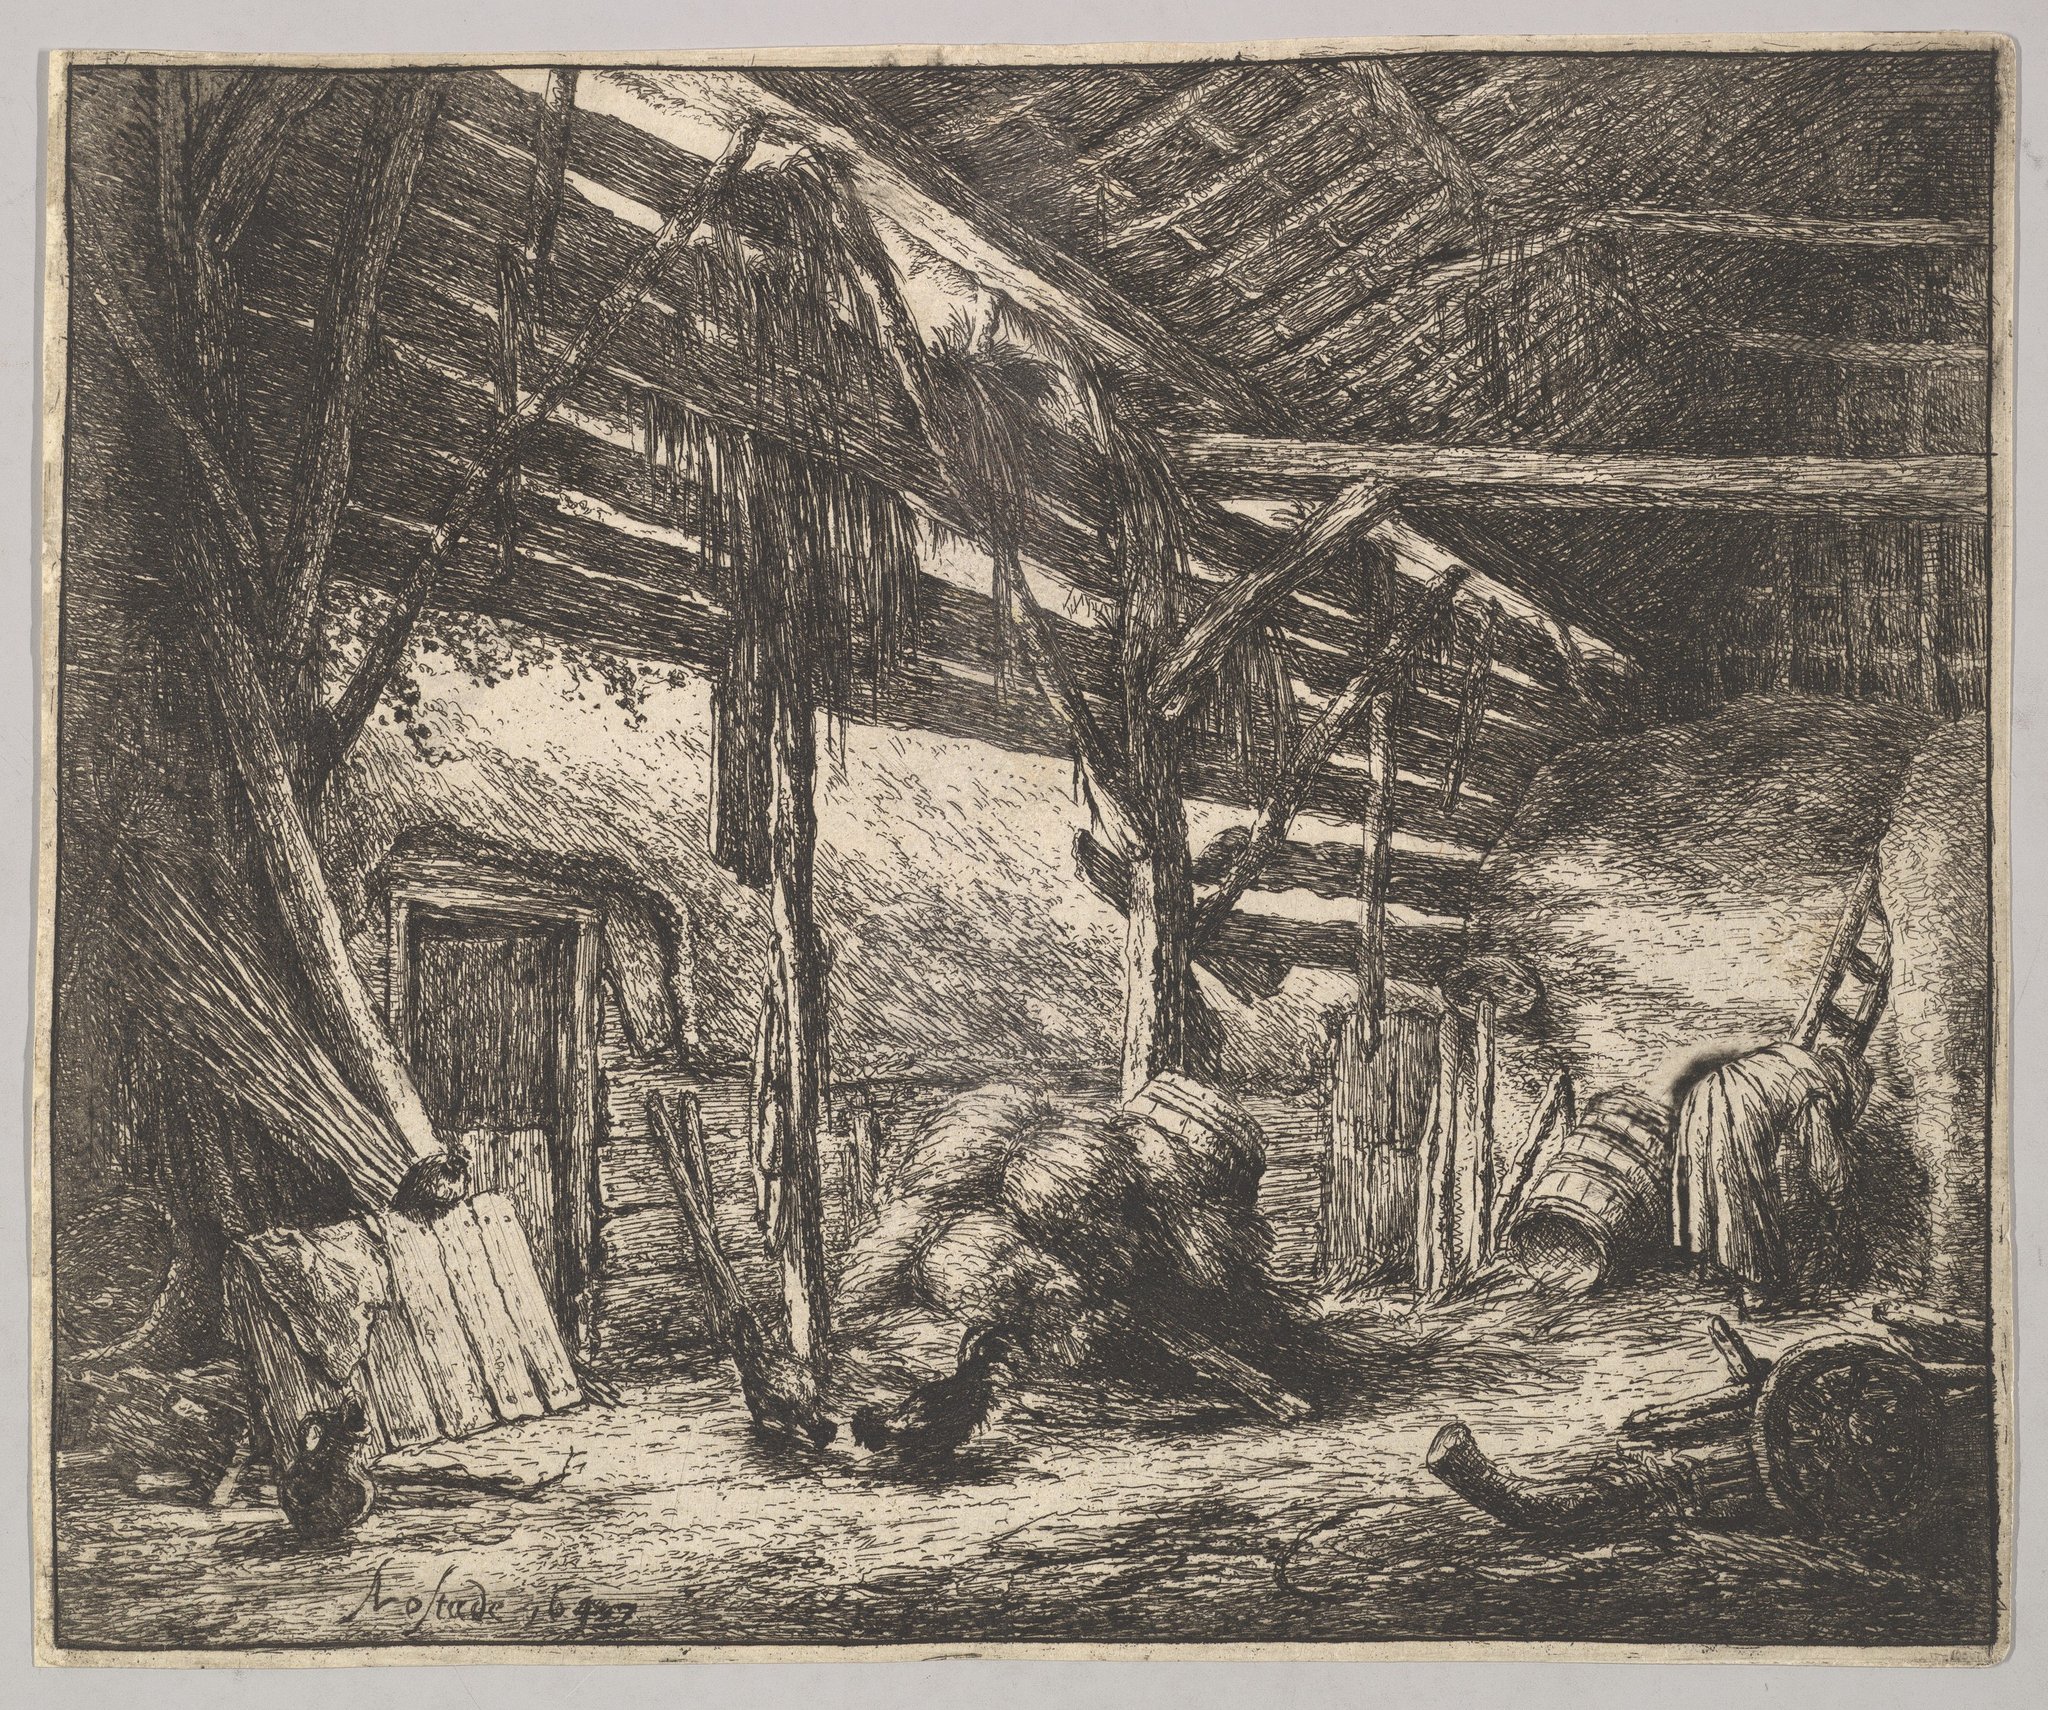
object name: print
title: The Barn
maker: adriaen van ostade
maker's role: artist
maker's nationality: dutch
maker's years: 1610-1685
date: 1647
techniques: etching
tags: barns,interiors